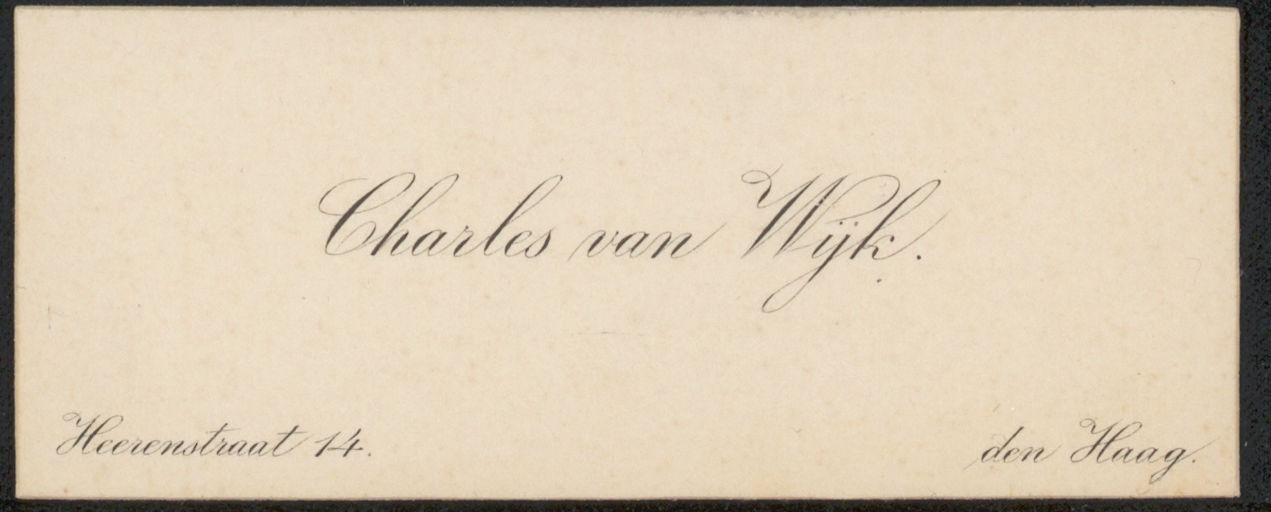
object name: visiting card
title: Visitekaartje aan Philip Zilcken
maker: charles van wijk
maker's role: sculptor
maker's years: 1875-1917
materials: cardboard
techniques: printing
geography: the hague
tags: the hague, painter, philip zilcken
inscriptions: collector's mark: ‘RPK’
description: Visitekaartje is samen met RP-D-1982-43-MARIS(ANNIE)-DOC.1A verstuurd in één envelop.